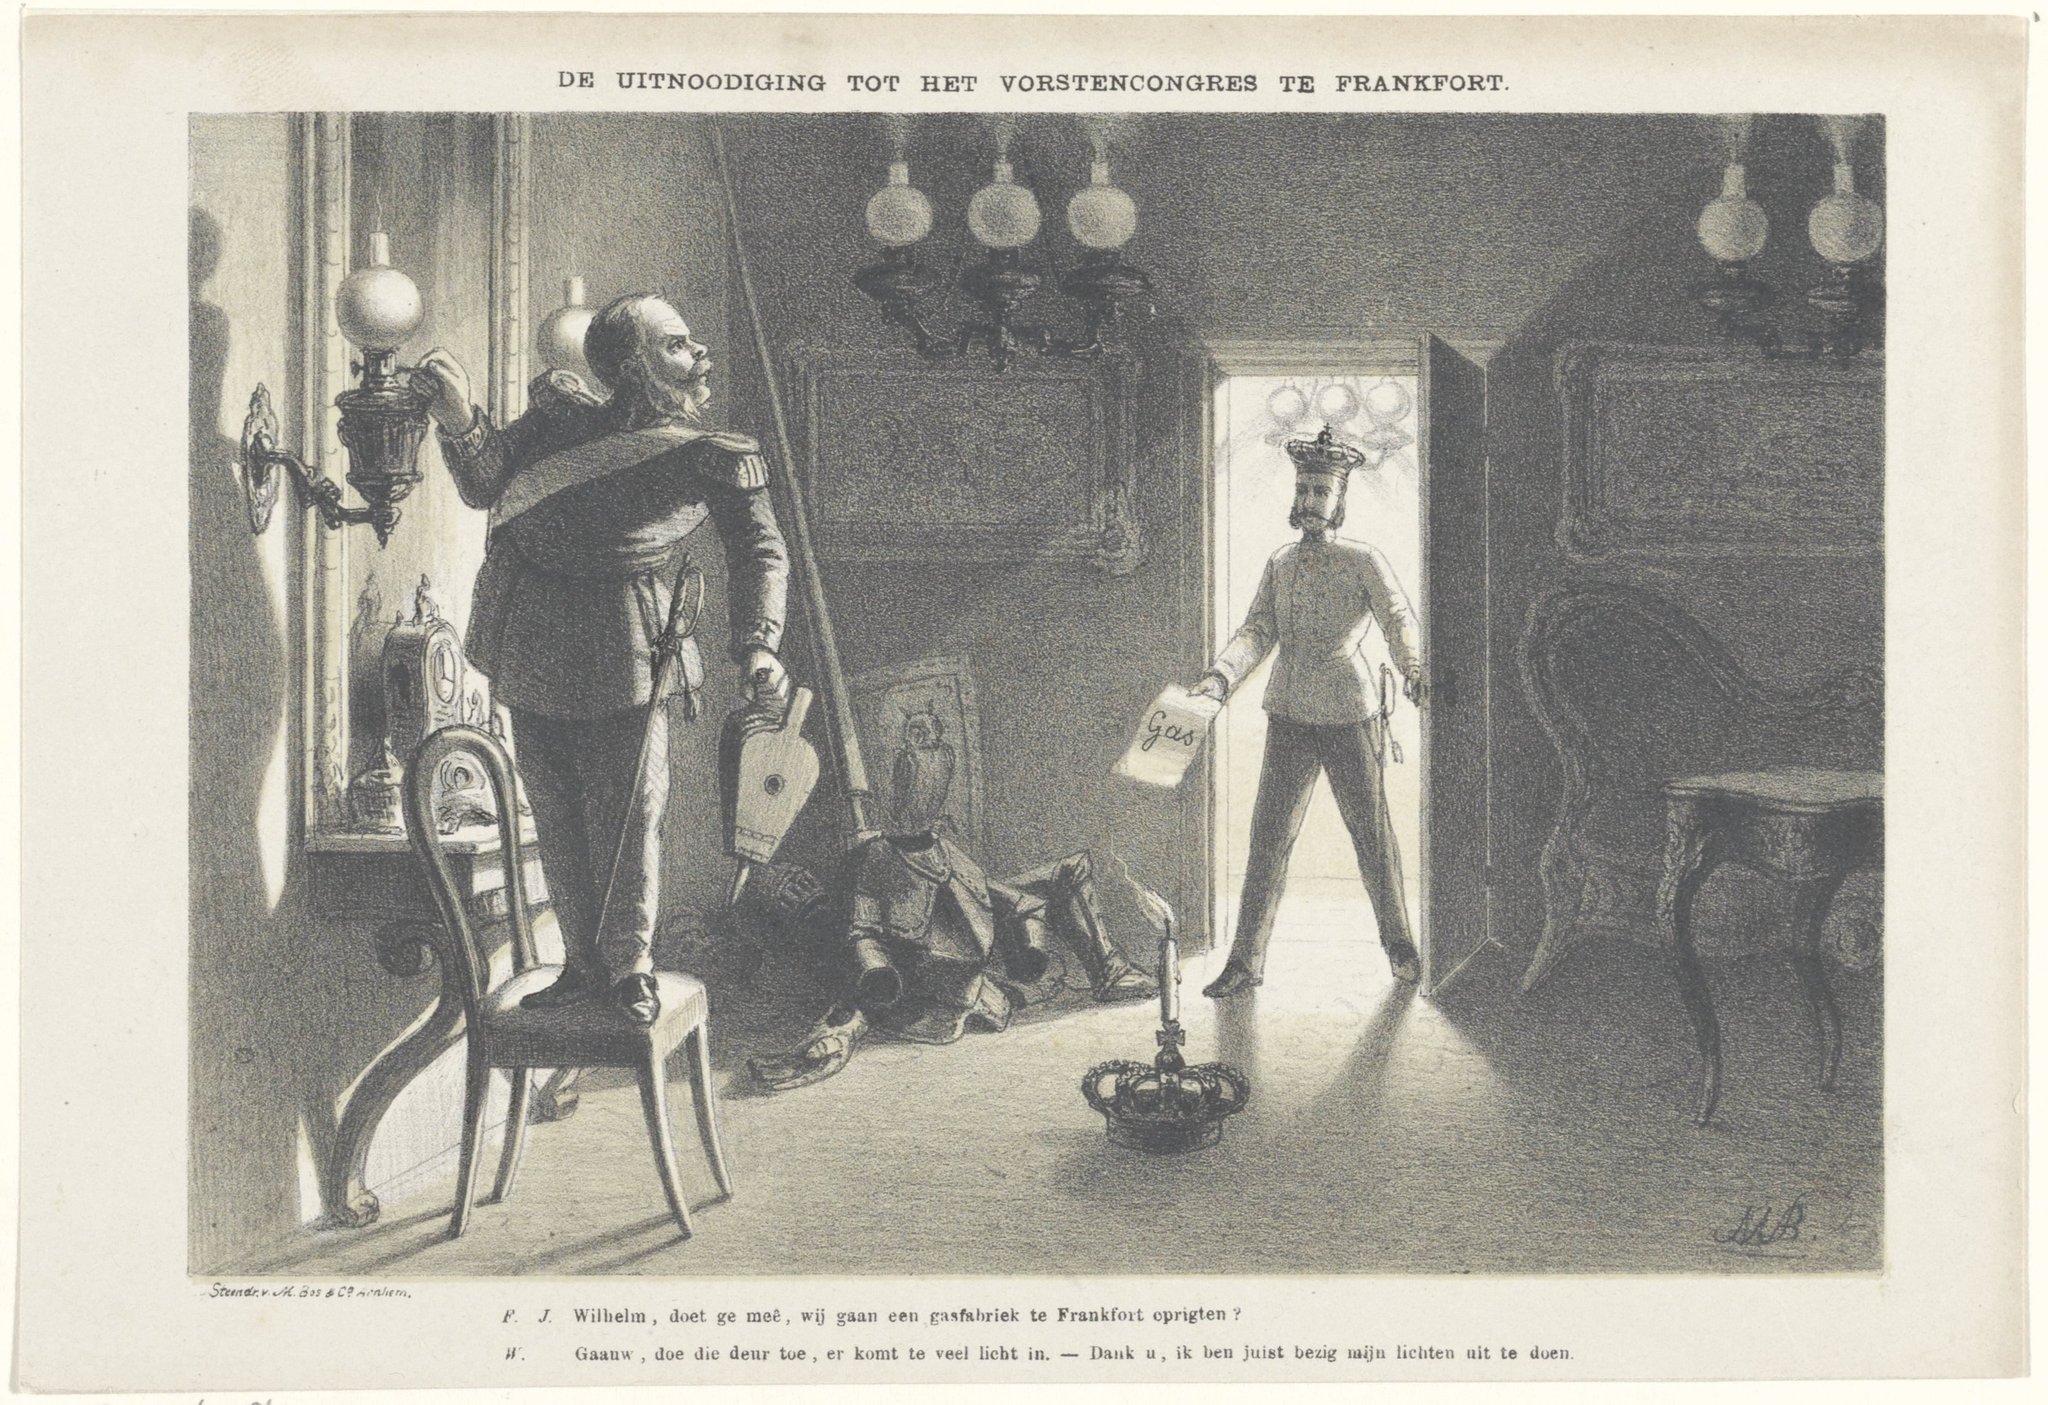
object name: print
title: De uitnoodiging tot het vorstencongres te Frankfort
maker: maarten bos jz.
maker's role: print maker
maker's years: 1831-1902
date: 1862-1867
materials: paper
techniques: tone lithography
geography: netherlands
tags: crown (symbol of sovereignty), lighting; lamps (+ extinguishing; extinguished light, lamp, candle), political caricatures and satires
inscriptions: collector's mark: Lugt 2228, collector's mark: Lugt 2760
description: Een man in militair uniform staat op een stoel om een lamp uit te draaien. Achter hem staat een man in de deuropening. Hij heeft een kroon op zijn hoofd. In zijn hand heeft hij een vel papier met daarop het woord: Gas. In de kamer hangen schilderijen, een spiegel en ligt een wapenuitrusting in de hoek op de grond.